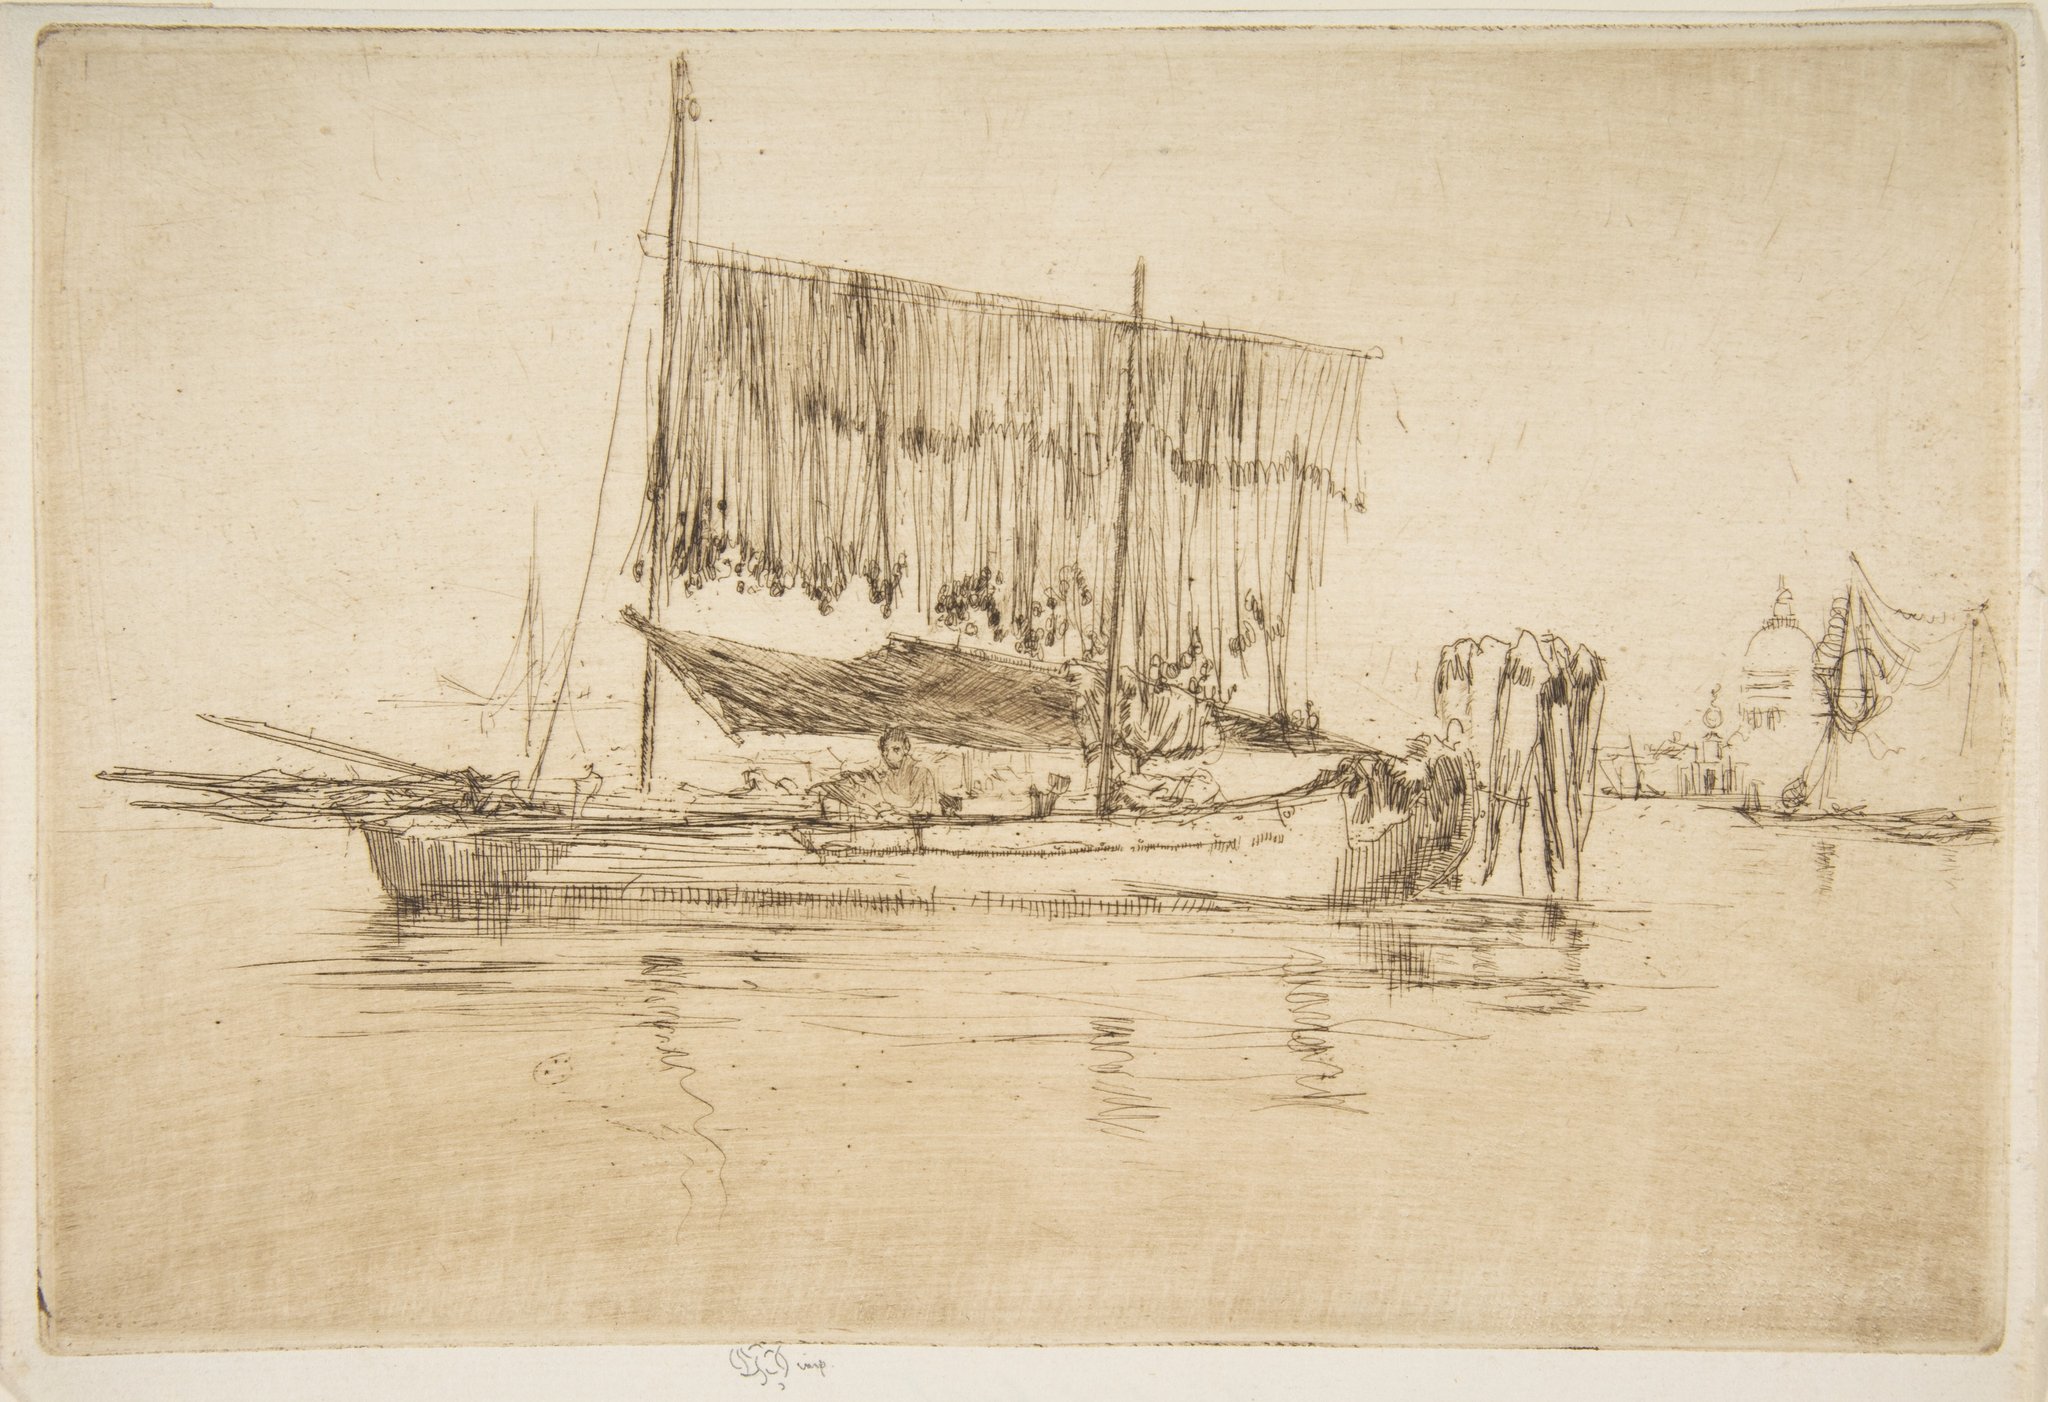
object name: print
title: Fishing Boat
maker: james mcneill whistler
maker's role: artist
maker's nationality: american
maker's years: 1834-1903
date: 1879-1880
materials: ink, paper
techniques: drypoint, etching, printing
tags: boats,venice